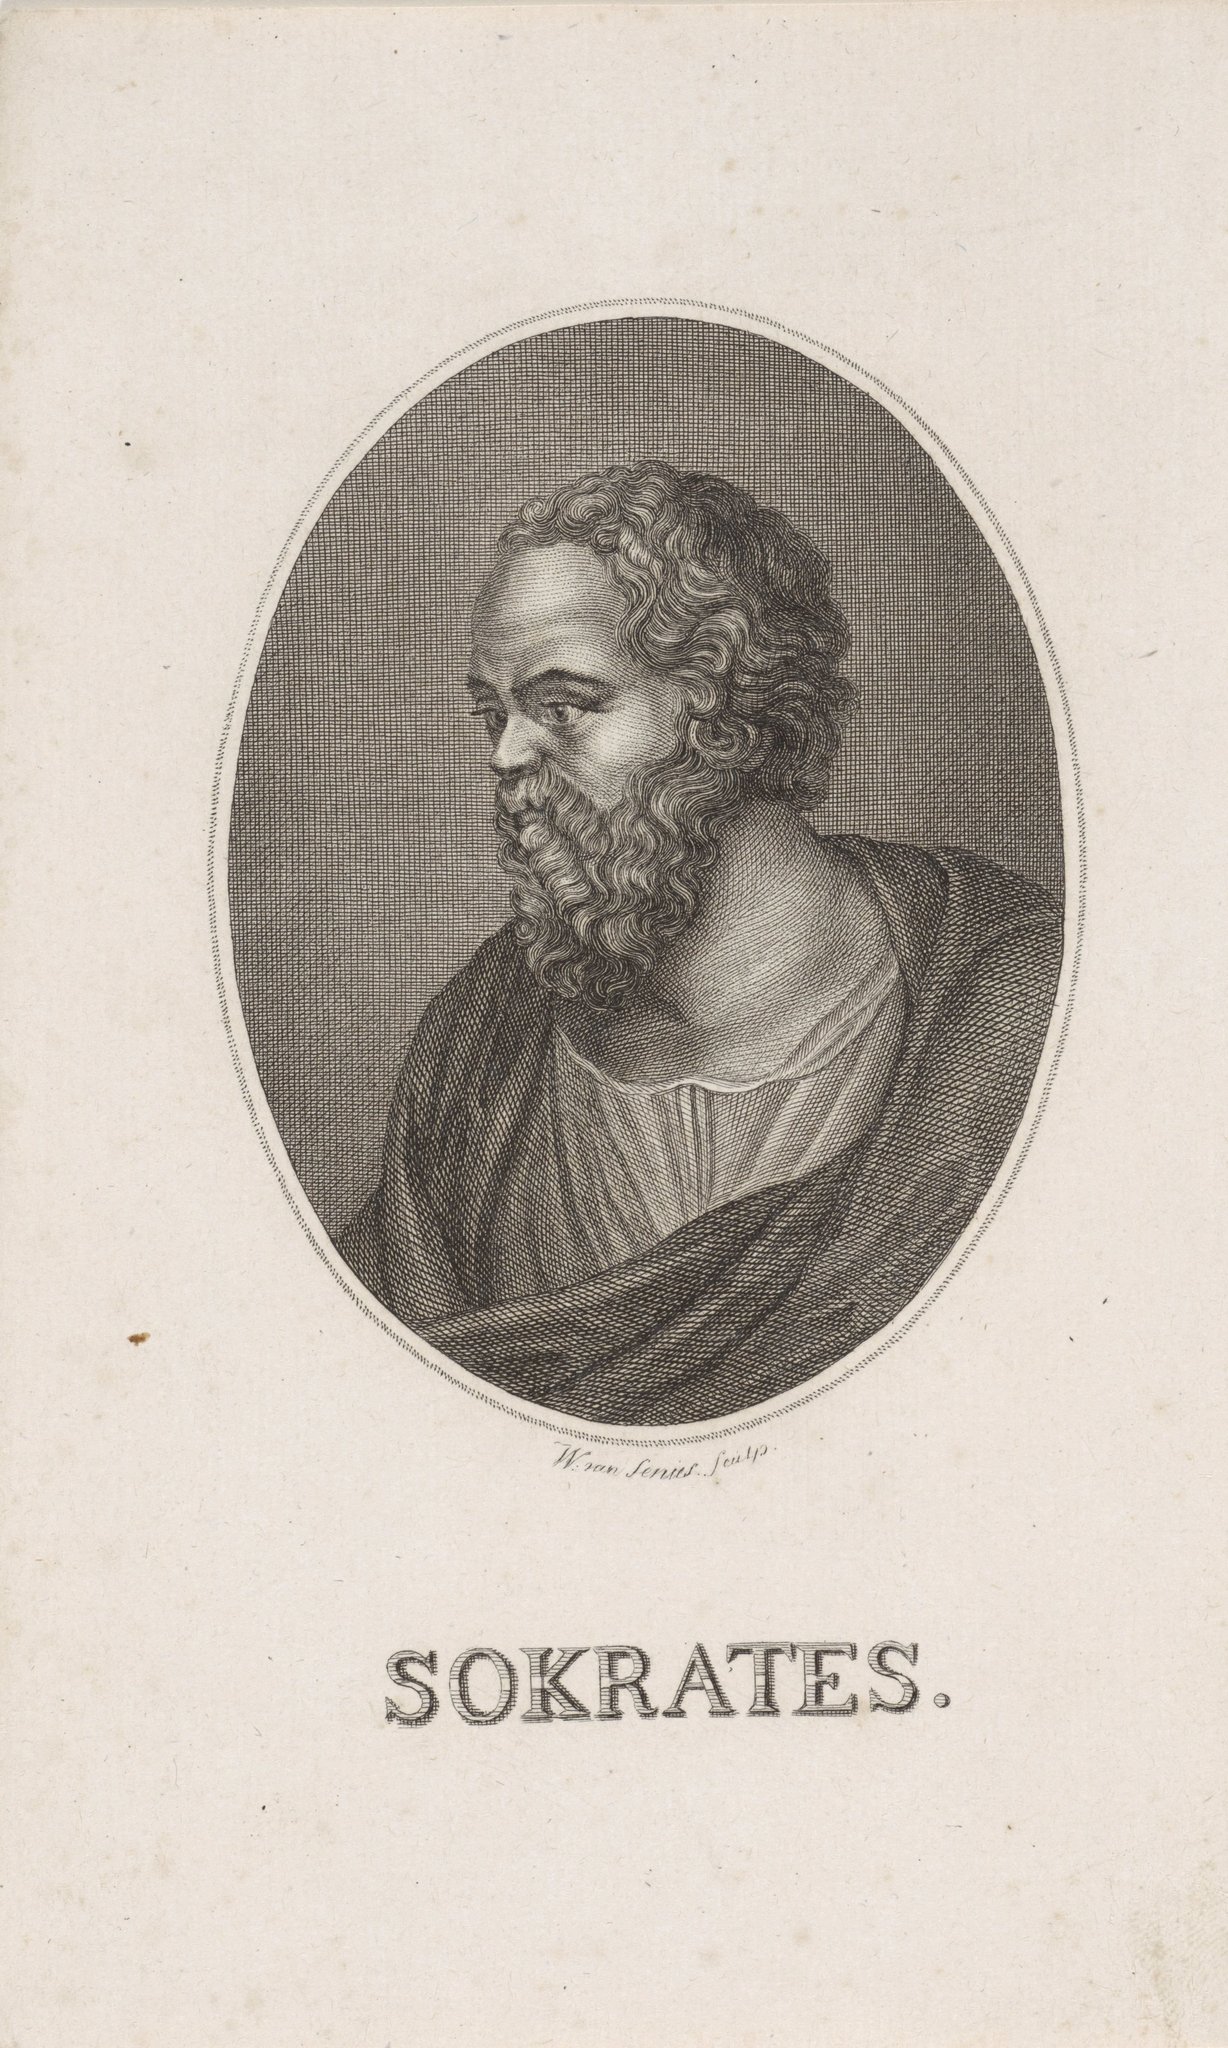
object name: print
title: Portret van Socrates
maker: willem van senus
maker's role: painter, print maker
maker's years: 1773-1851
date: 1783-1851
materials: paper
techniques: engraving, etching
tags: filosoof, socrates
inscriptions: collector's mark: Lugt 2228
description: Portret van de Griekse filosoof Socrates.